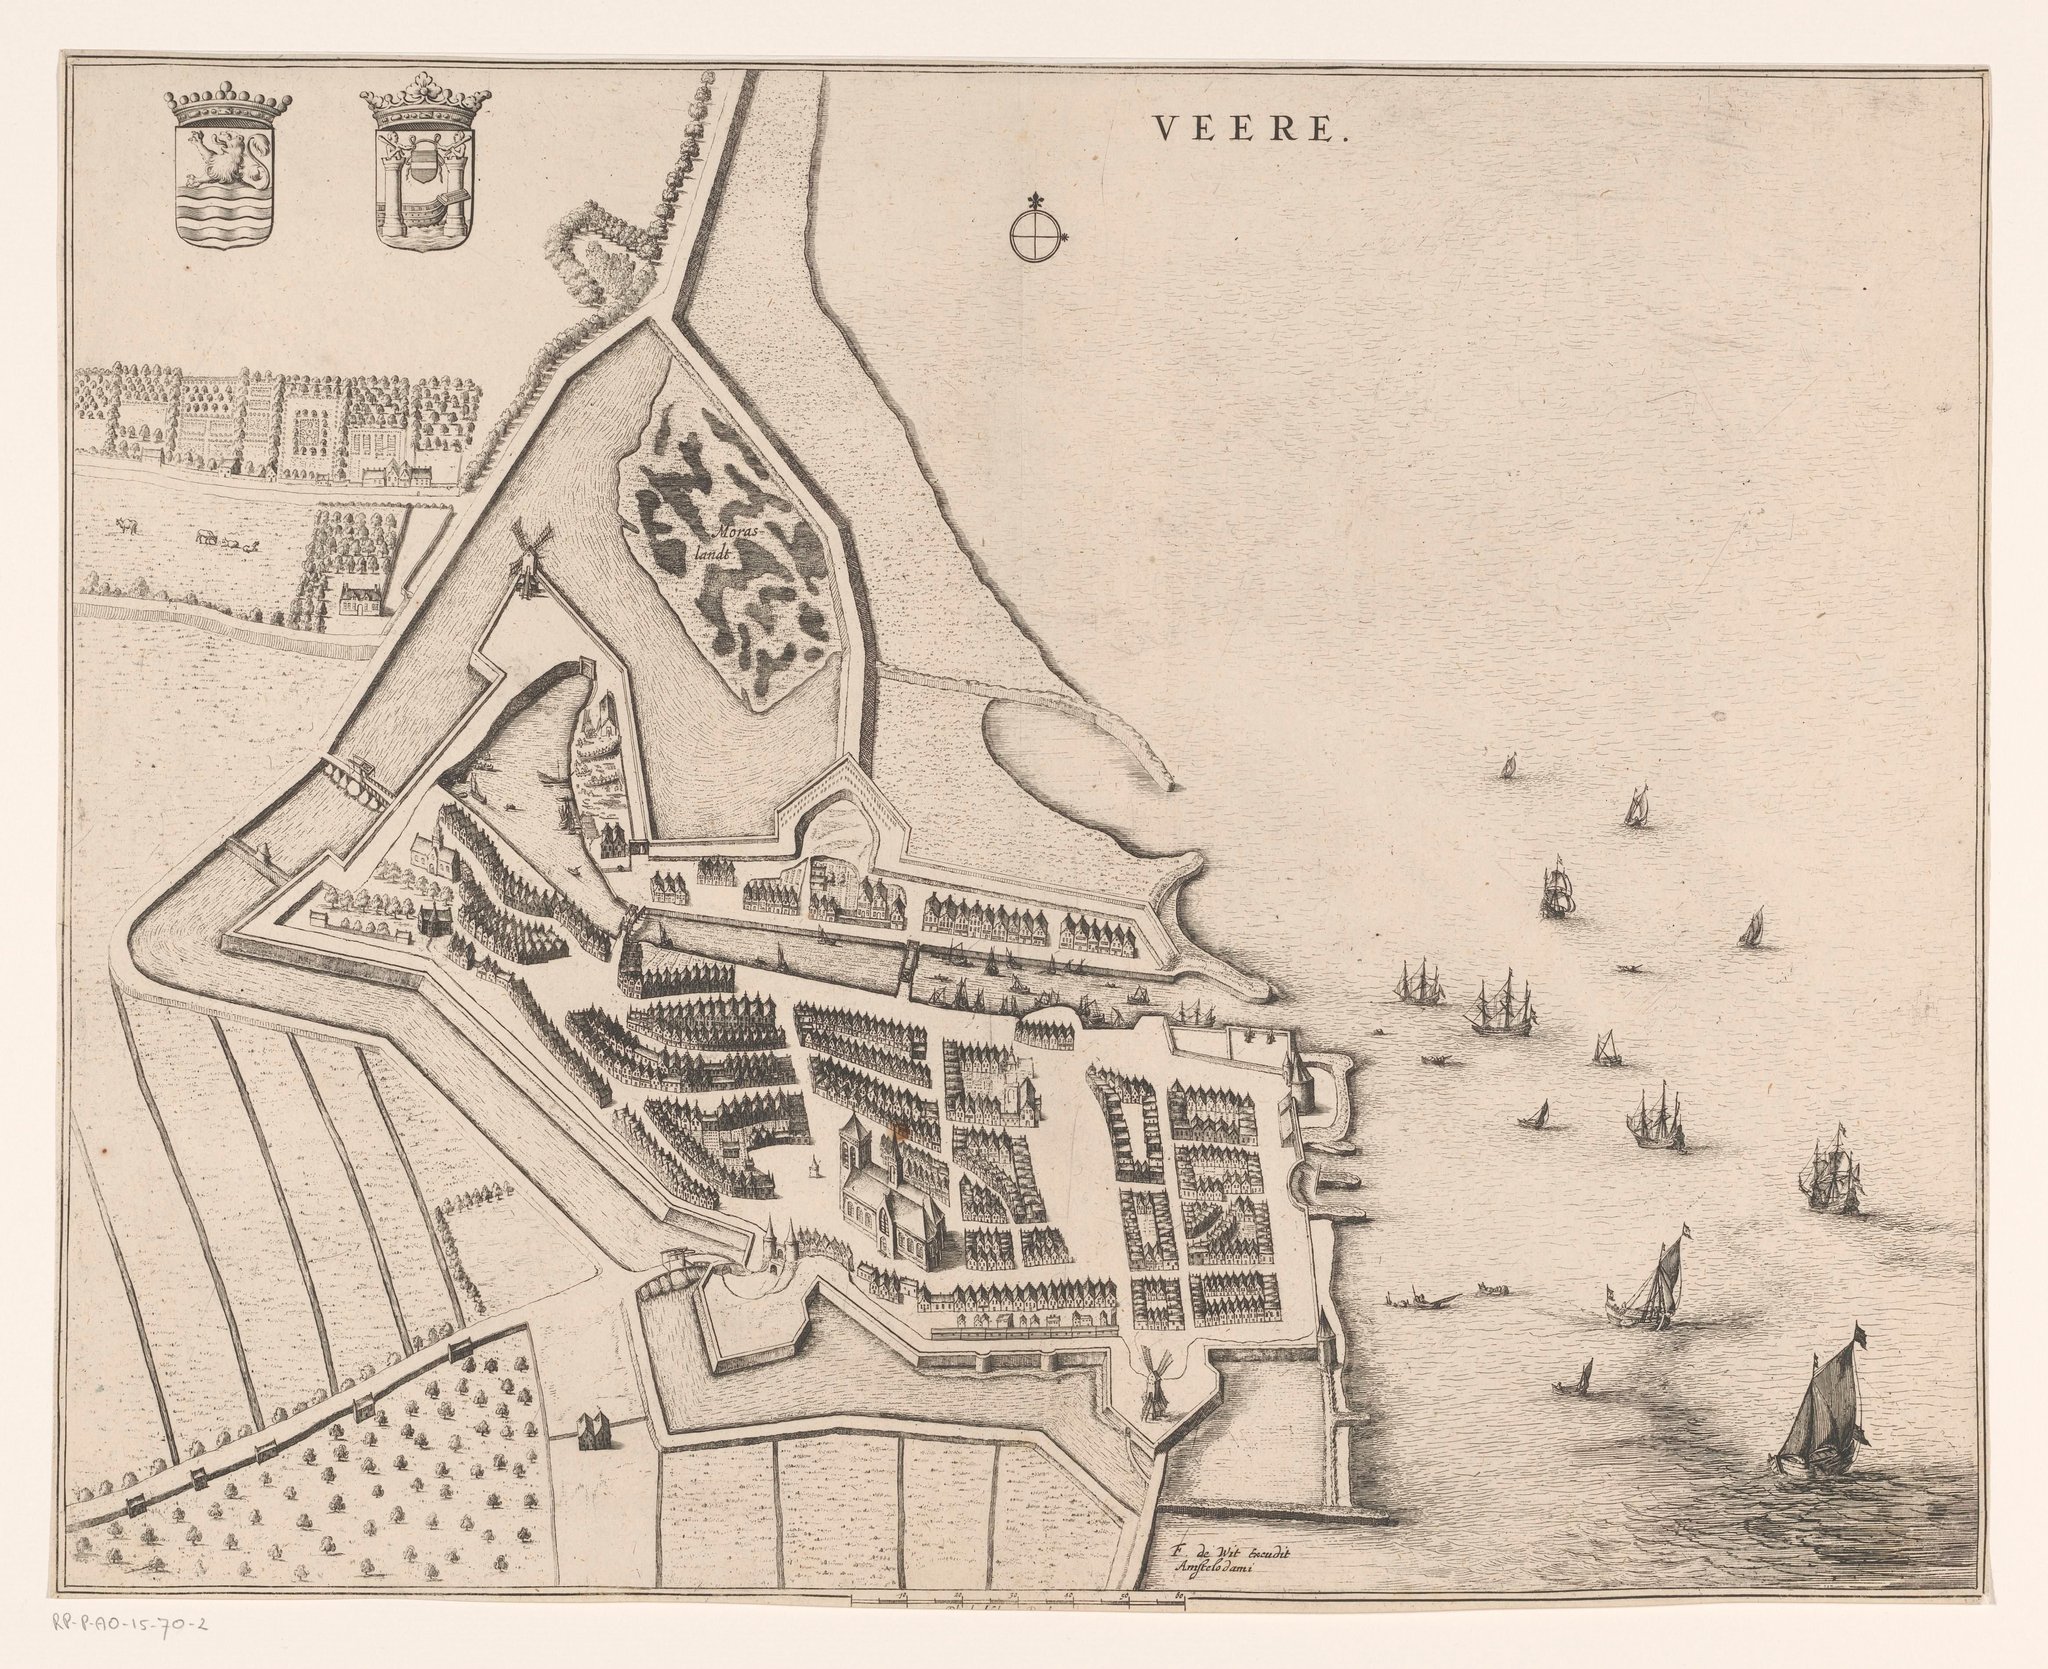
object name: area plan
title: Plattegrond van Veere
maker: Anonymous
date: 1649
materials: paper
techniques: engraving, etching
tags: coat of arms (as symbol of the state, etc.) (+ city; municipal), maps of cities, coat of arms (as symbol of the state, etc.) (+ province; provincial)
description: Deze staat van prent ook gebruikt in: Theatrum ichnographicum omnium urbium et praecipuorum oppidorum Belgicarum XVII Provinciarum (…). Amsterdam: Frederik de Wit, ca. 1700-1710. En in: Aa, Pieter van der. La galerie agreable du monde (...). 66 delen. Leiden: Pieter van der Aa, 1728, dl. 21.